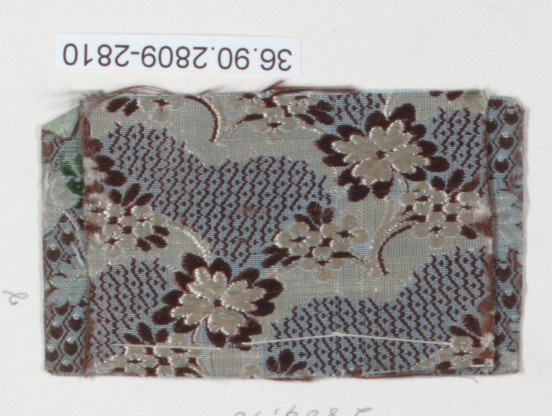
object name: piece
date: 1801-1900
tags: flowers